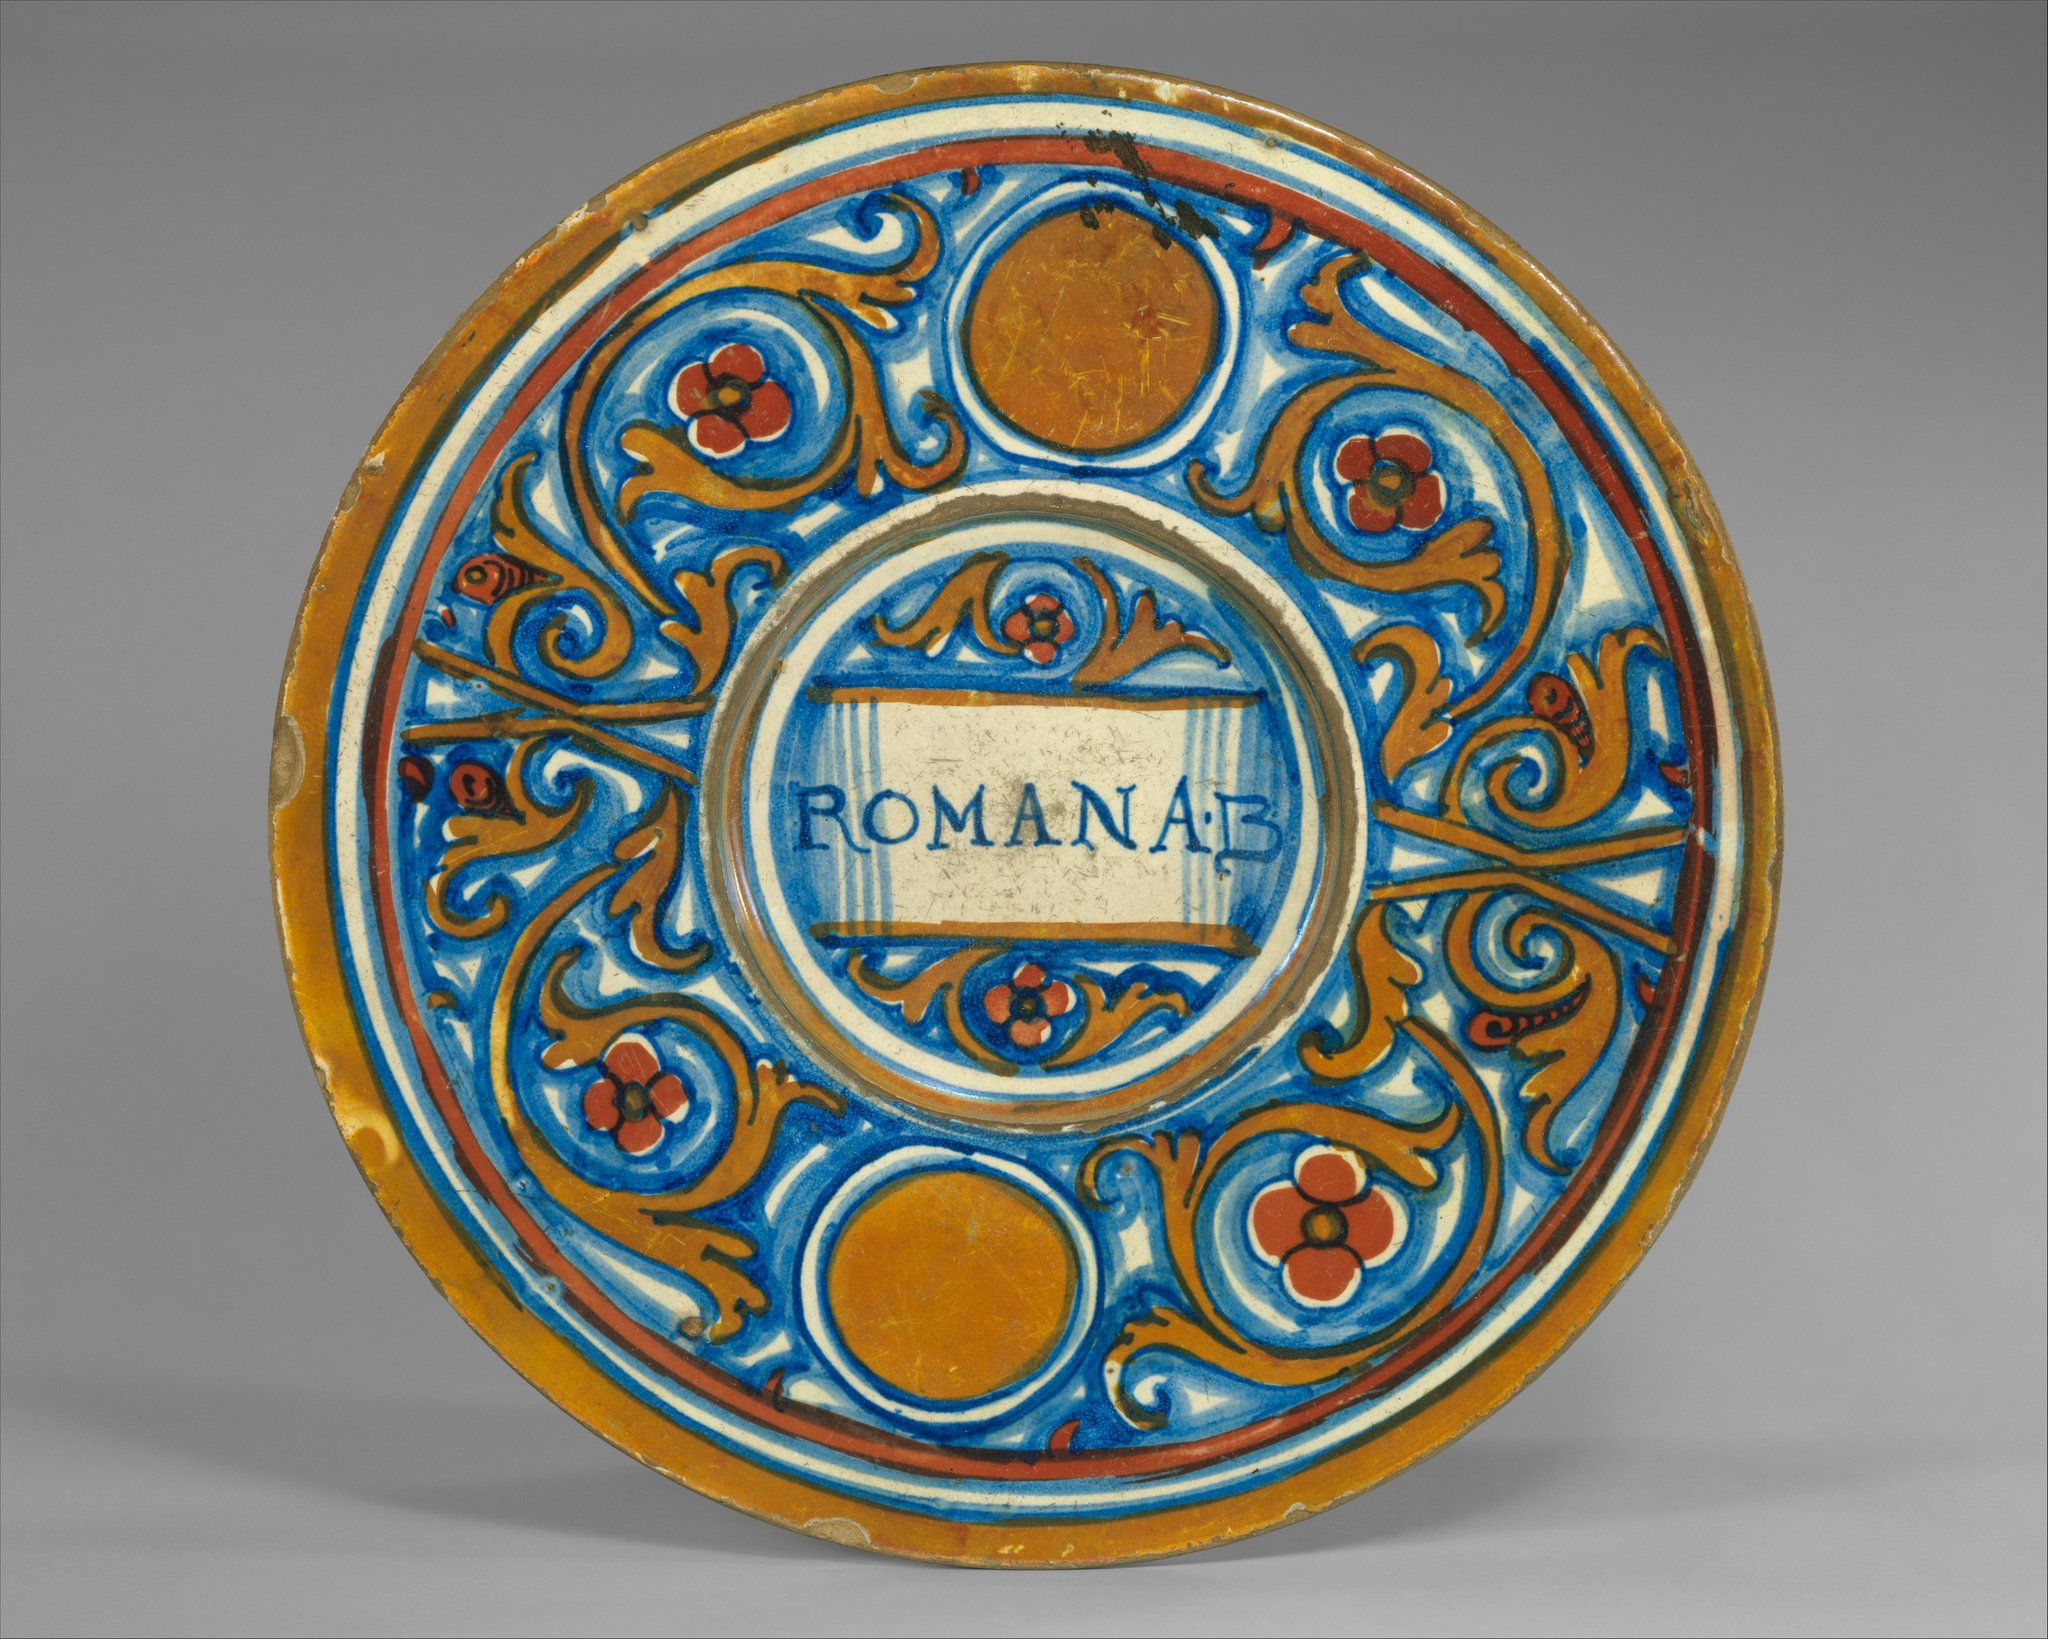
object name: plate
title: Plate (tagliere)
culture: italian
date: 1530-1535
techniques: maiolica, glazing